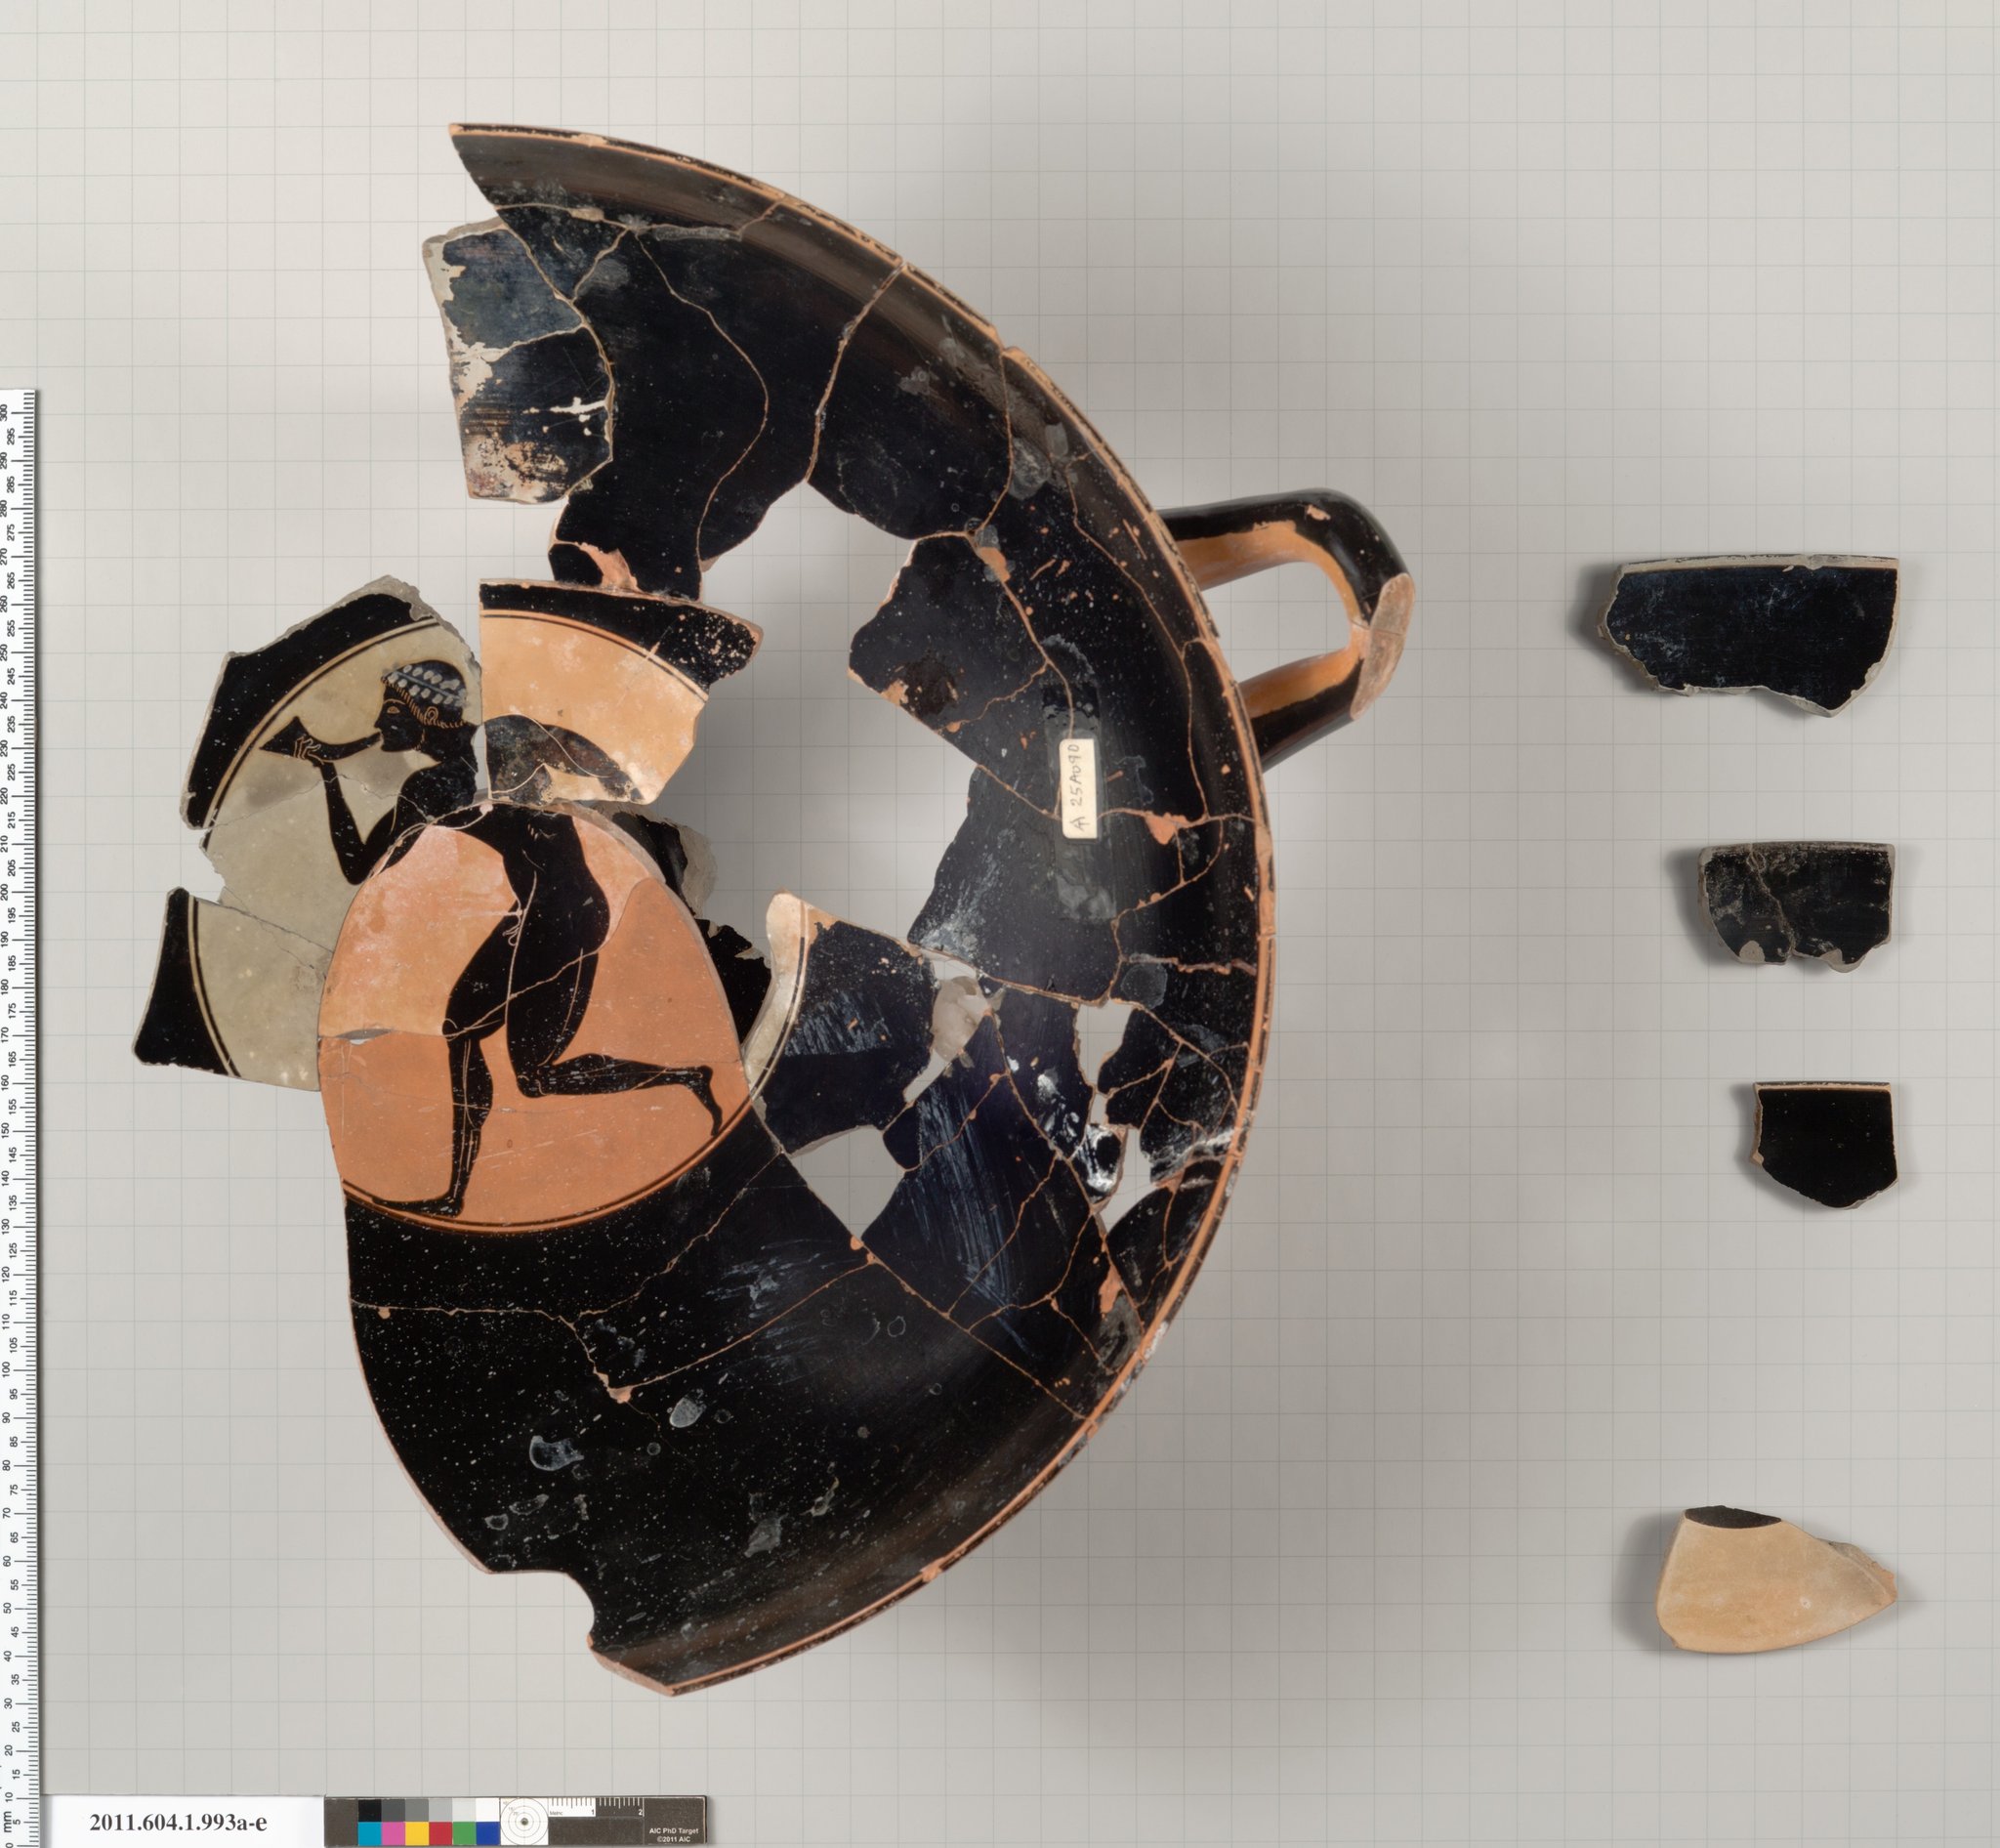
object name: kylix fragment, eye cup, bilingual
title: Terracotta kylix: eye cup (drinking cup)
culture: greek, attic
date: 515-510 BCE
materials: terracotta